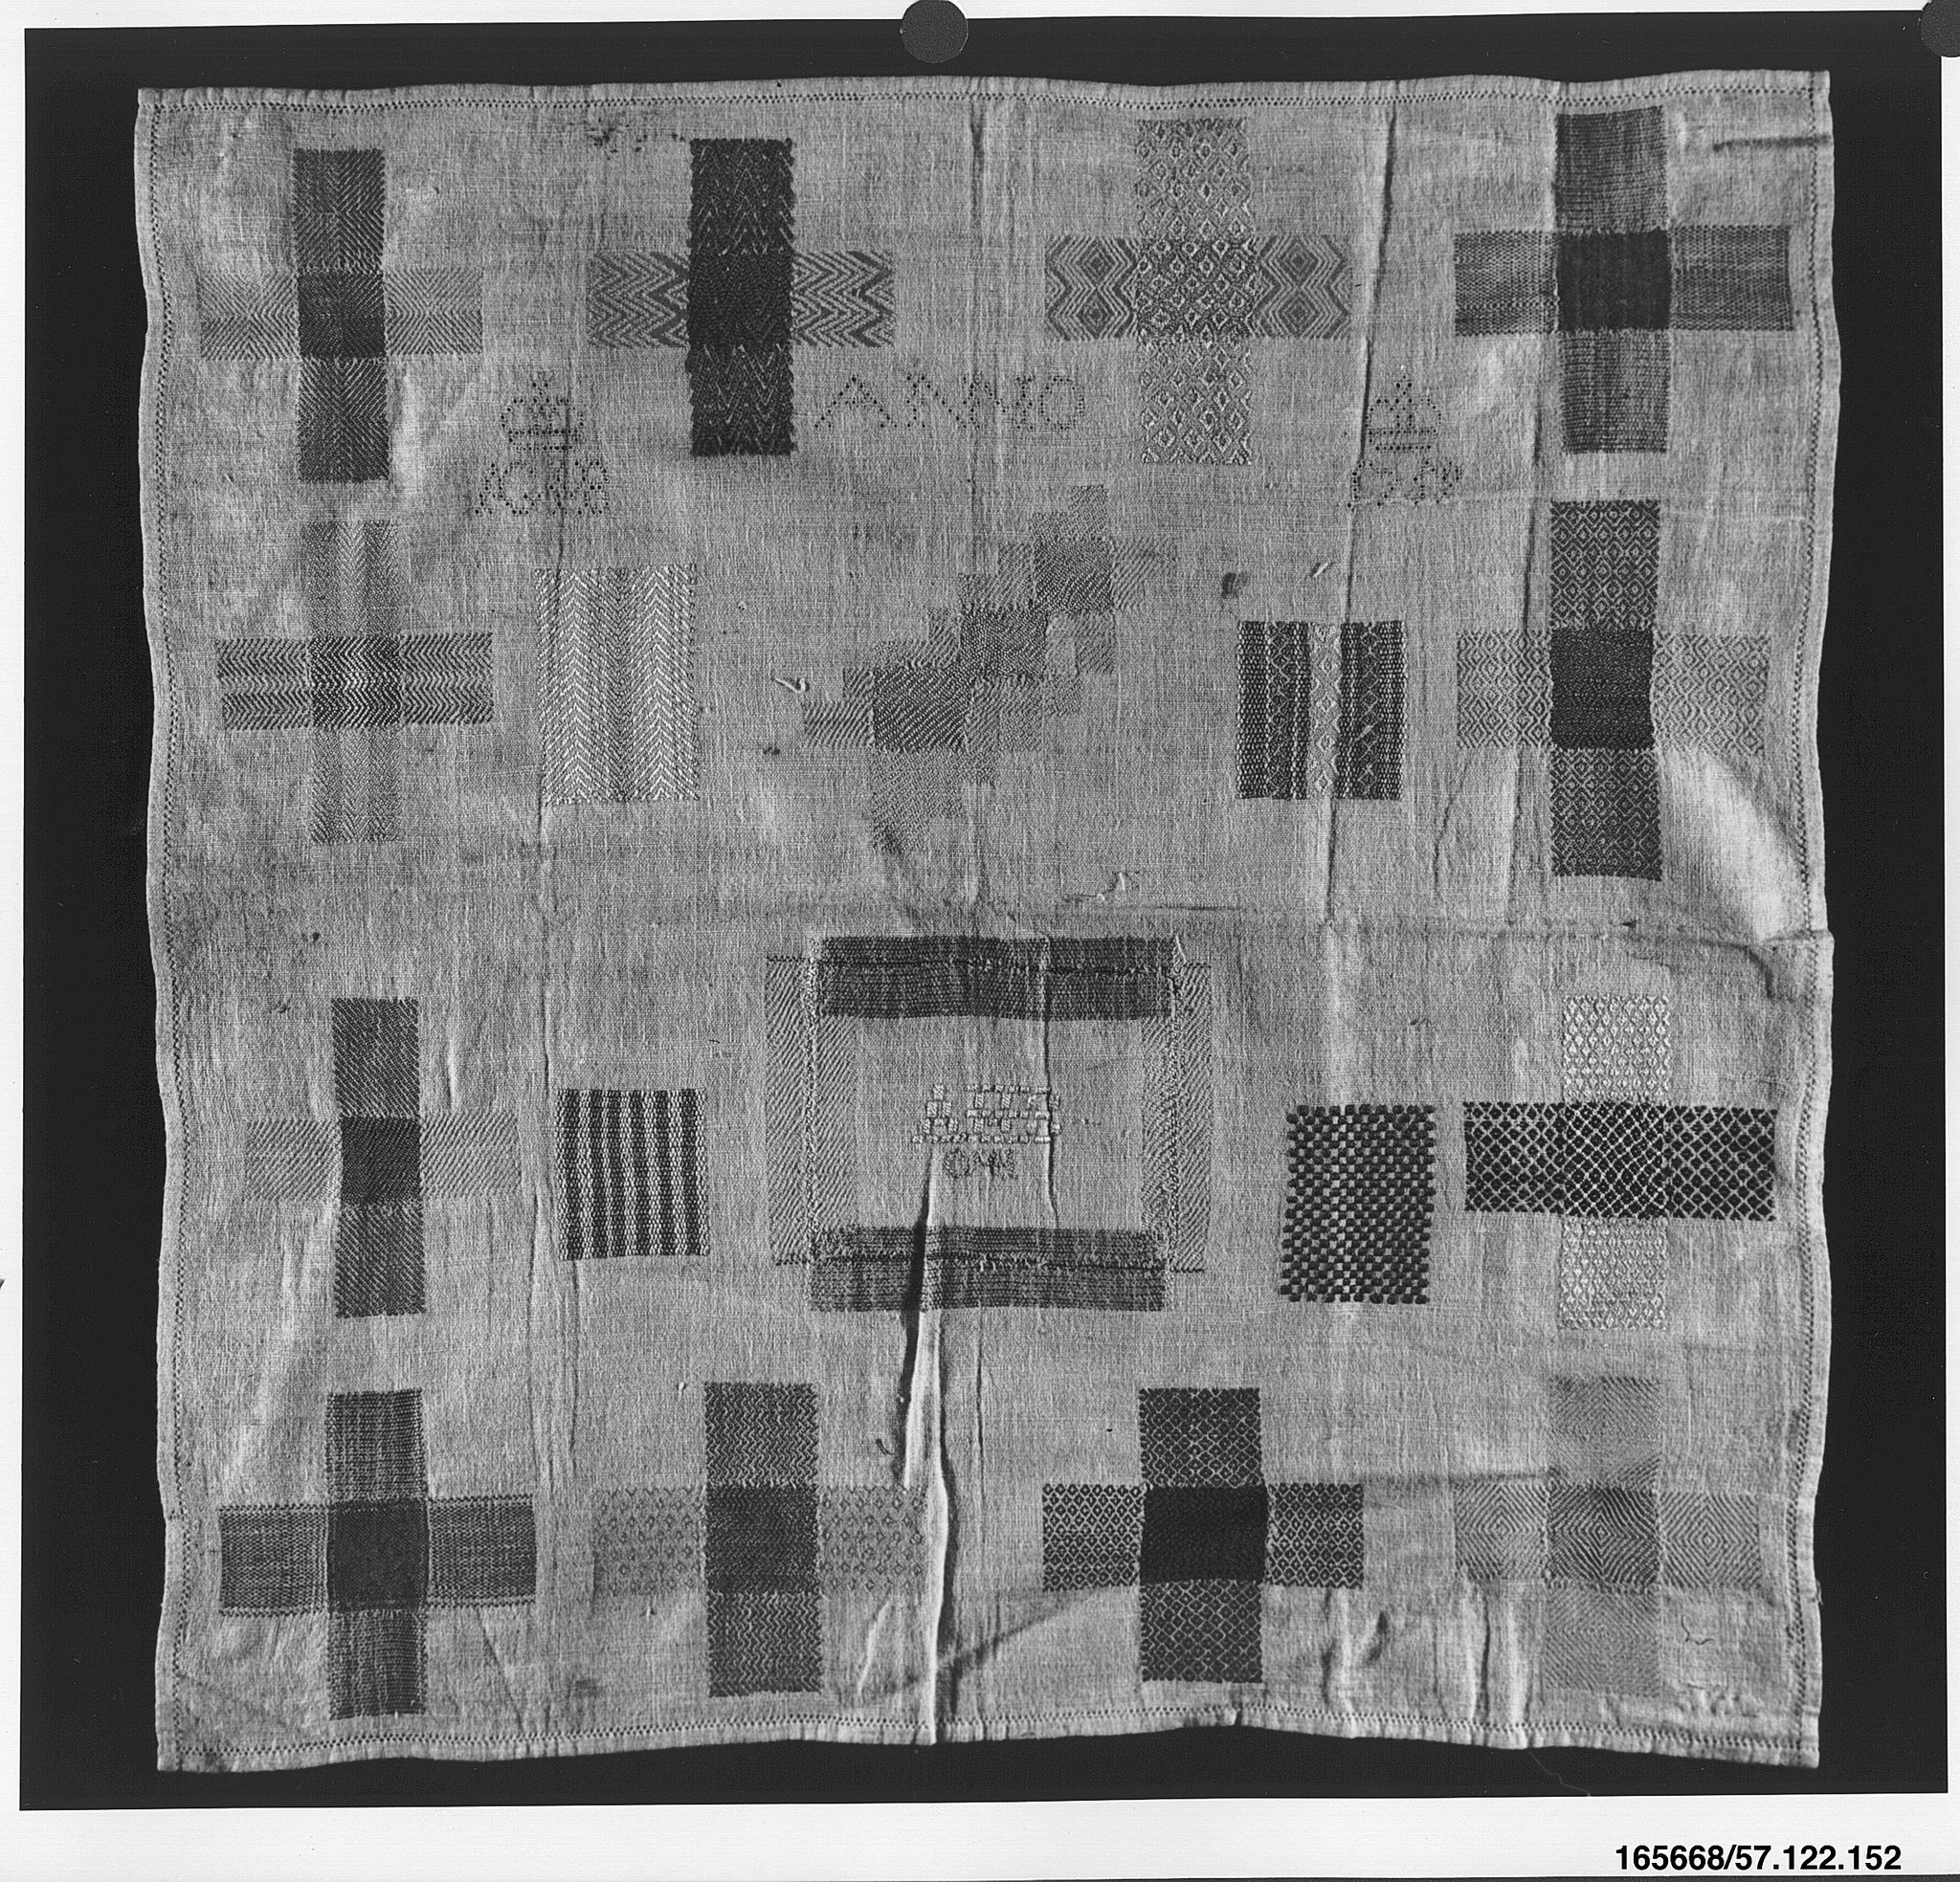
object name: sampler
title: Embroidered darning sampler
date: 1759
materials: cotton, silk